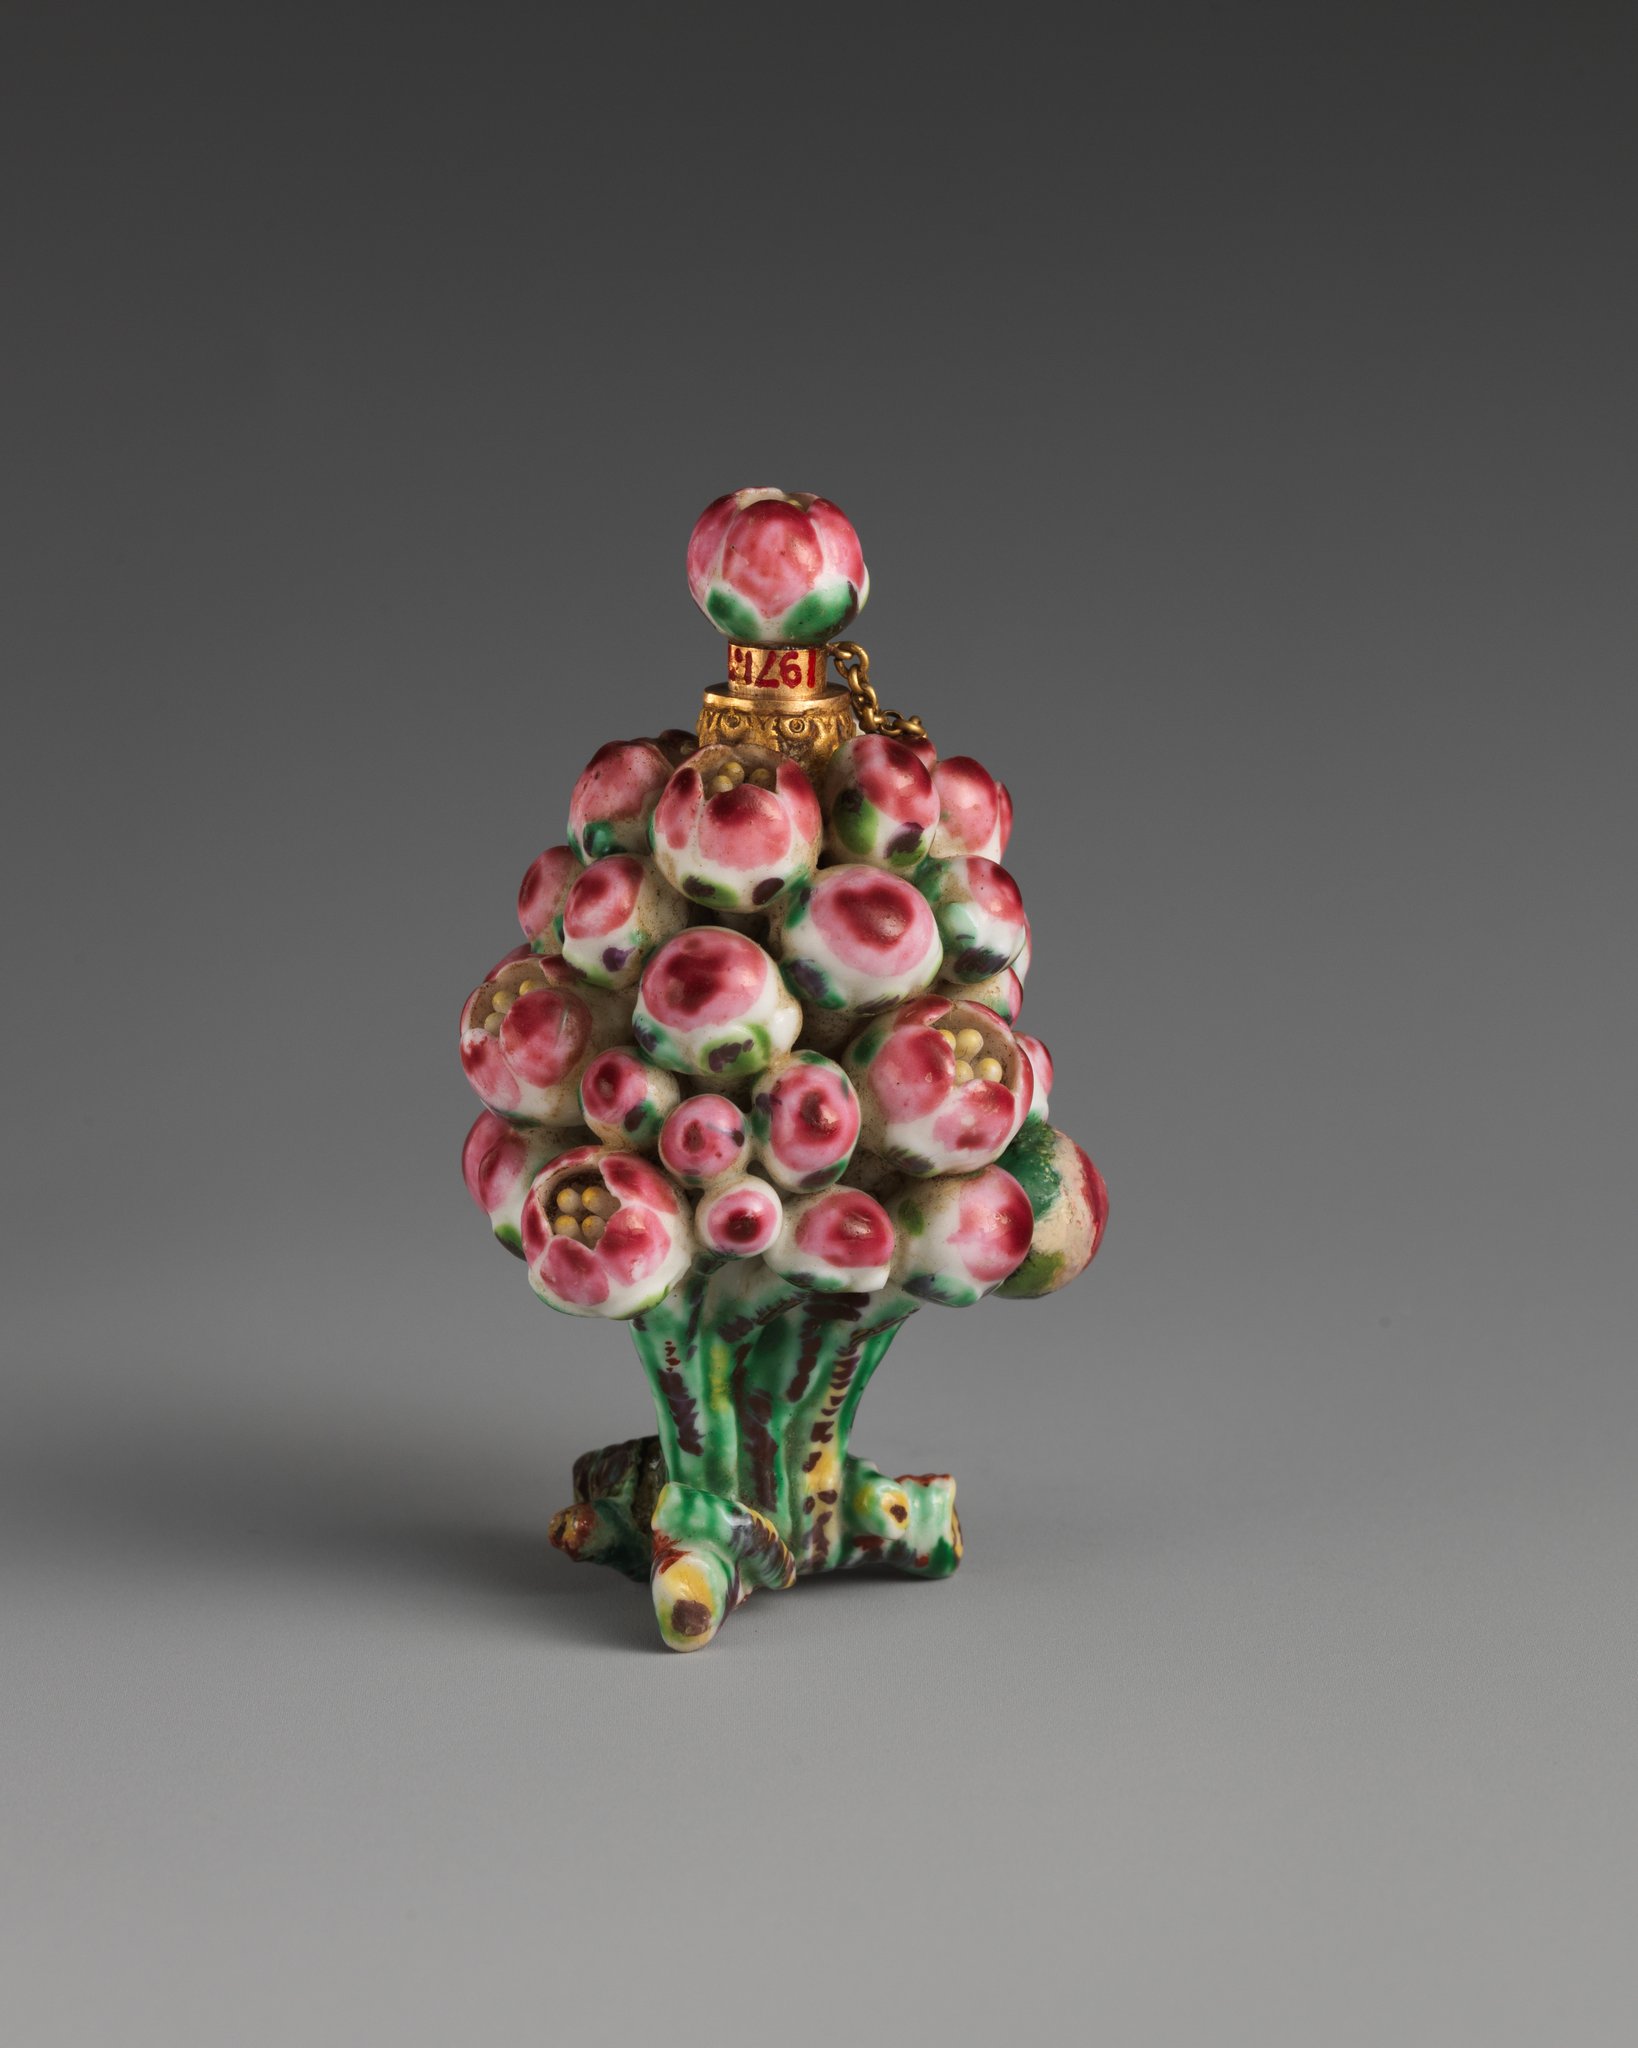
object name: scent bottle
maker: saint james's factory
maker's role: maker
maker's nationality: british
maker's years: 1749-1759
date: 1750-1755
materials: soft paste porcelain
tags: flowers